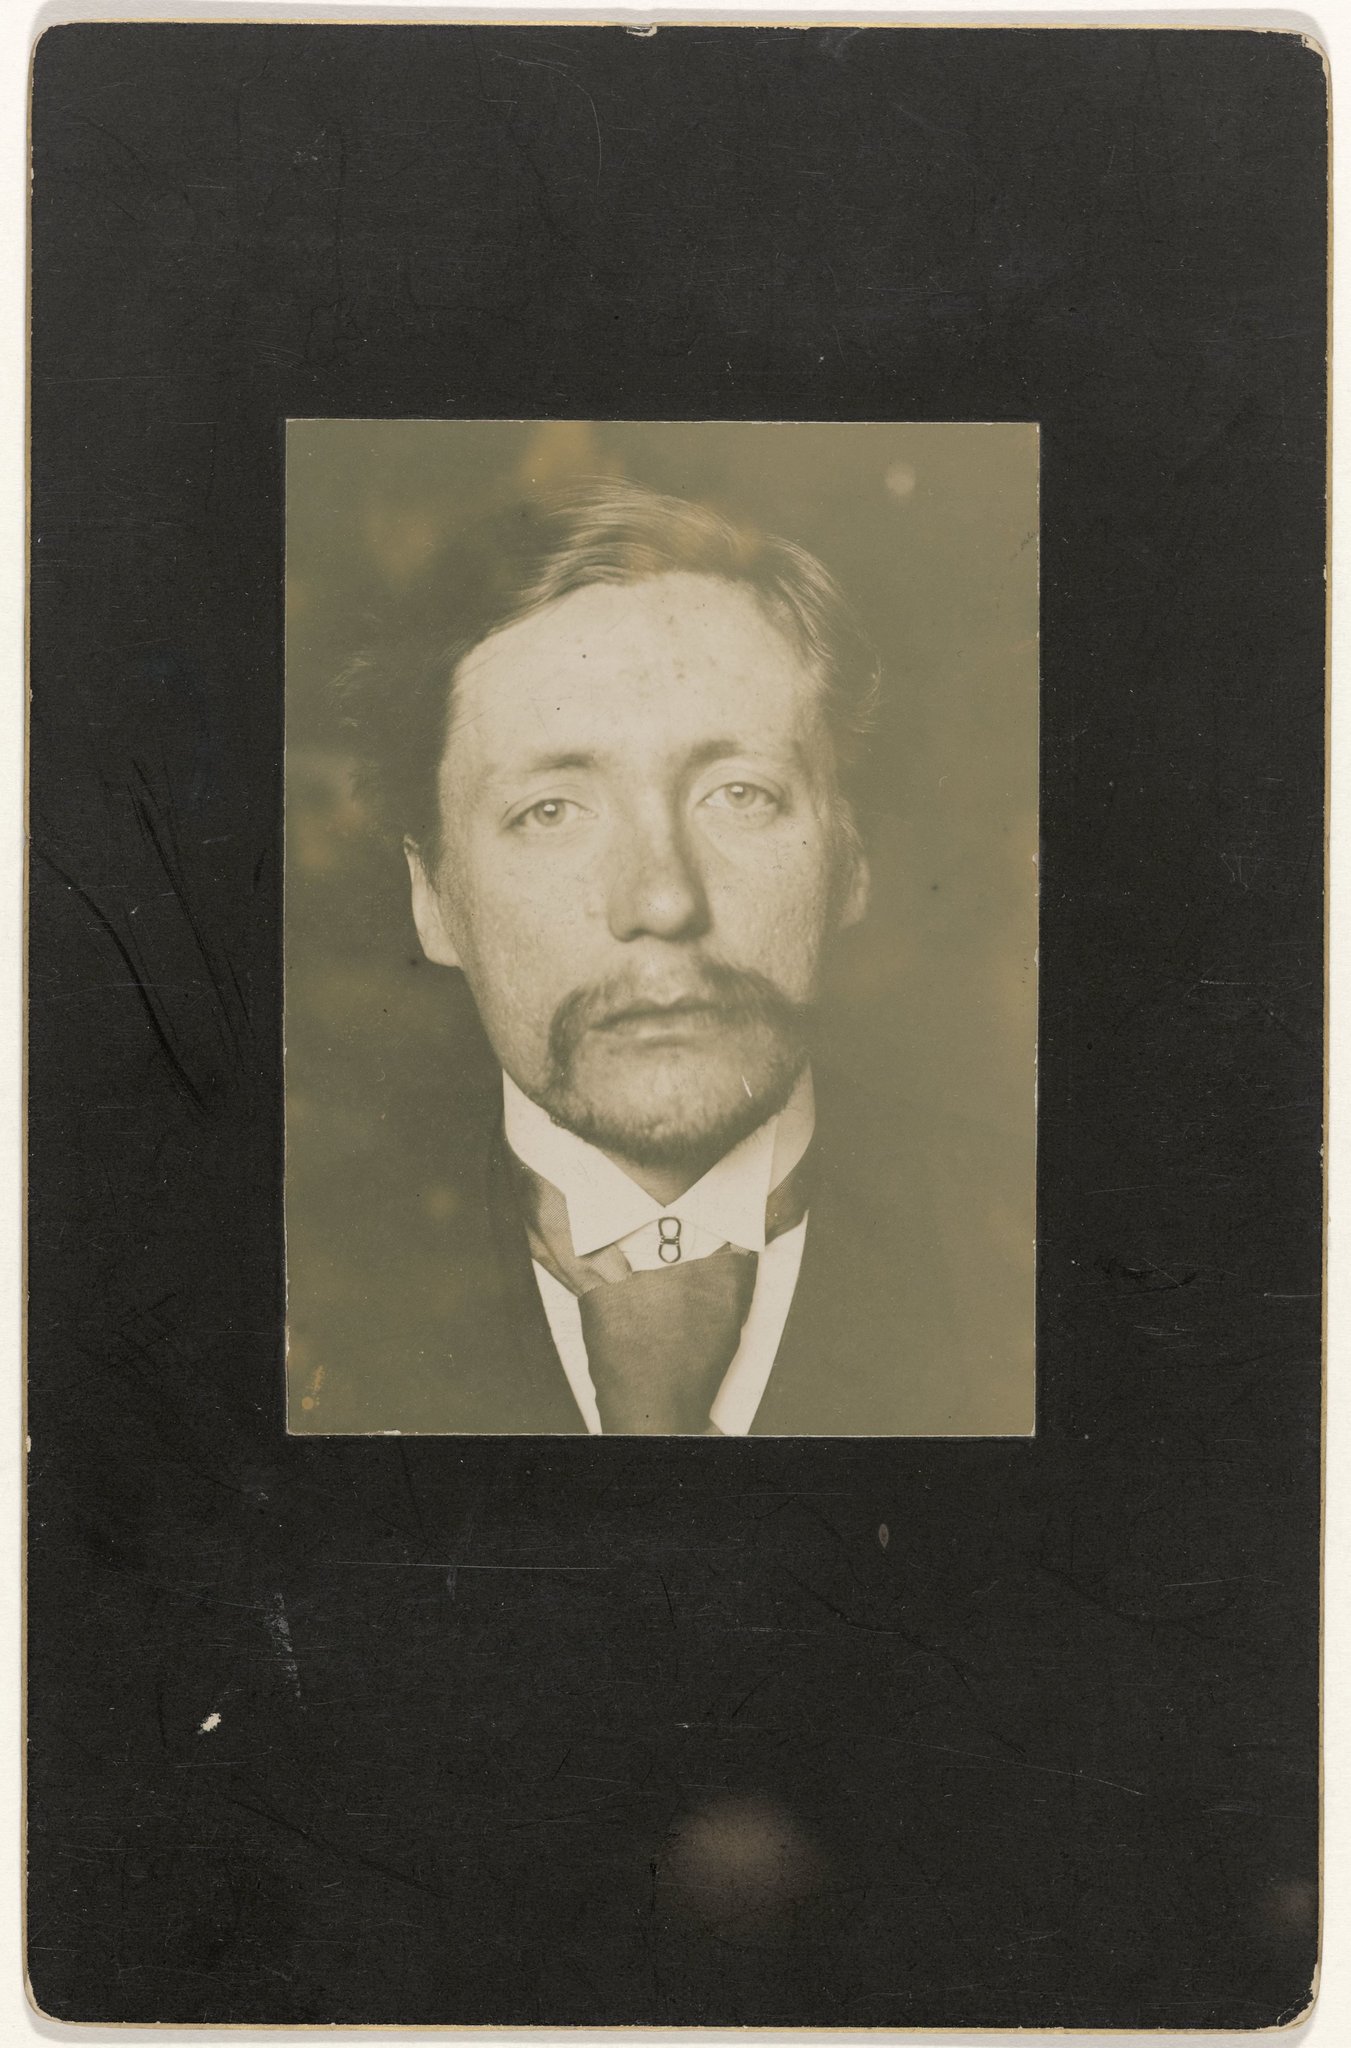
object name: photograph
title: Portret van Willem Kloos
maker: willem witsen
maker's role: draughtsman, painter, print maker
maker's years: 1860-1923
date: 1894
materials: cardboard, paper, photographic support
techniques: gelatin silver print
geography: amsterdam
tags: amsterdam, the hague, willem kloos, historical persons (portraits and scenes from the life)